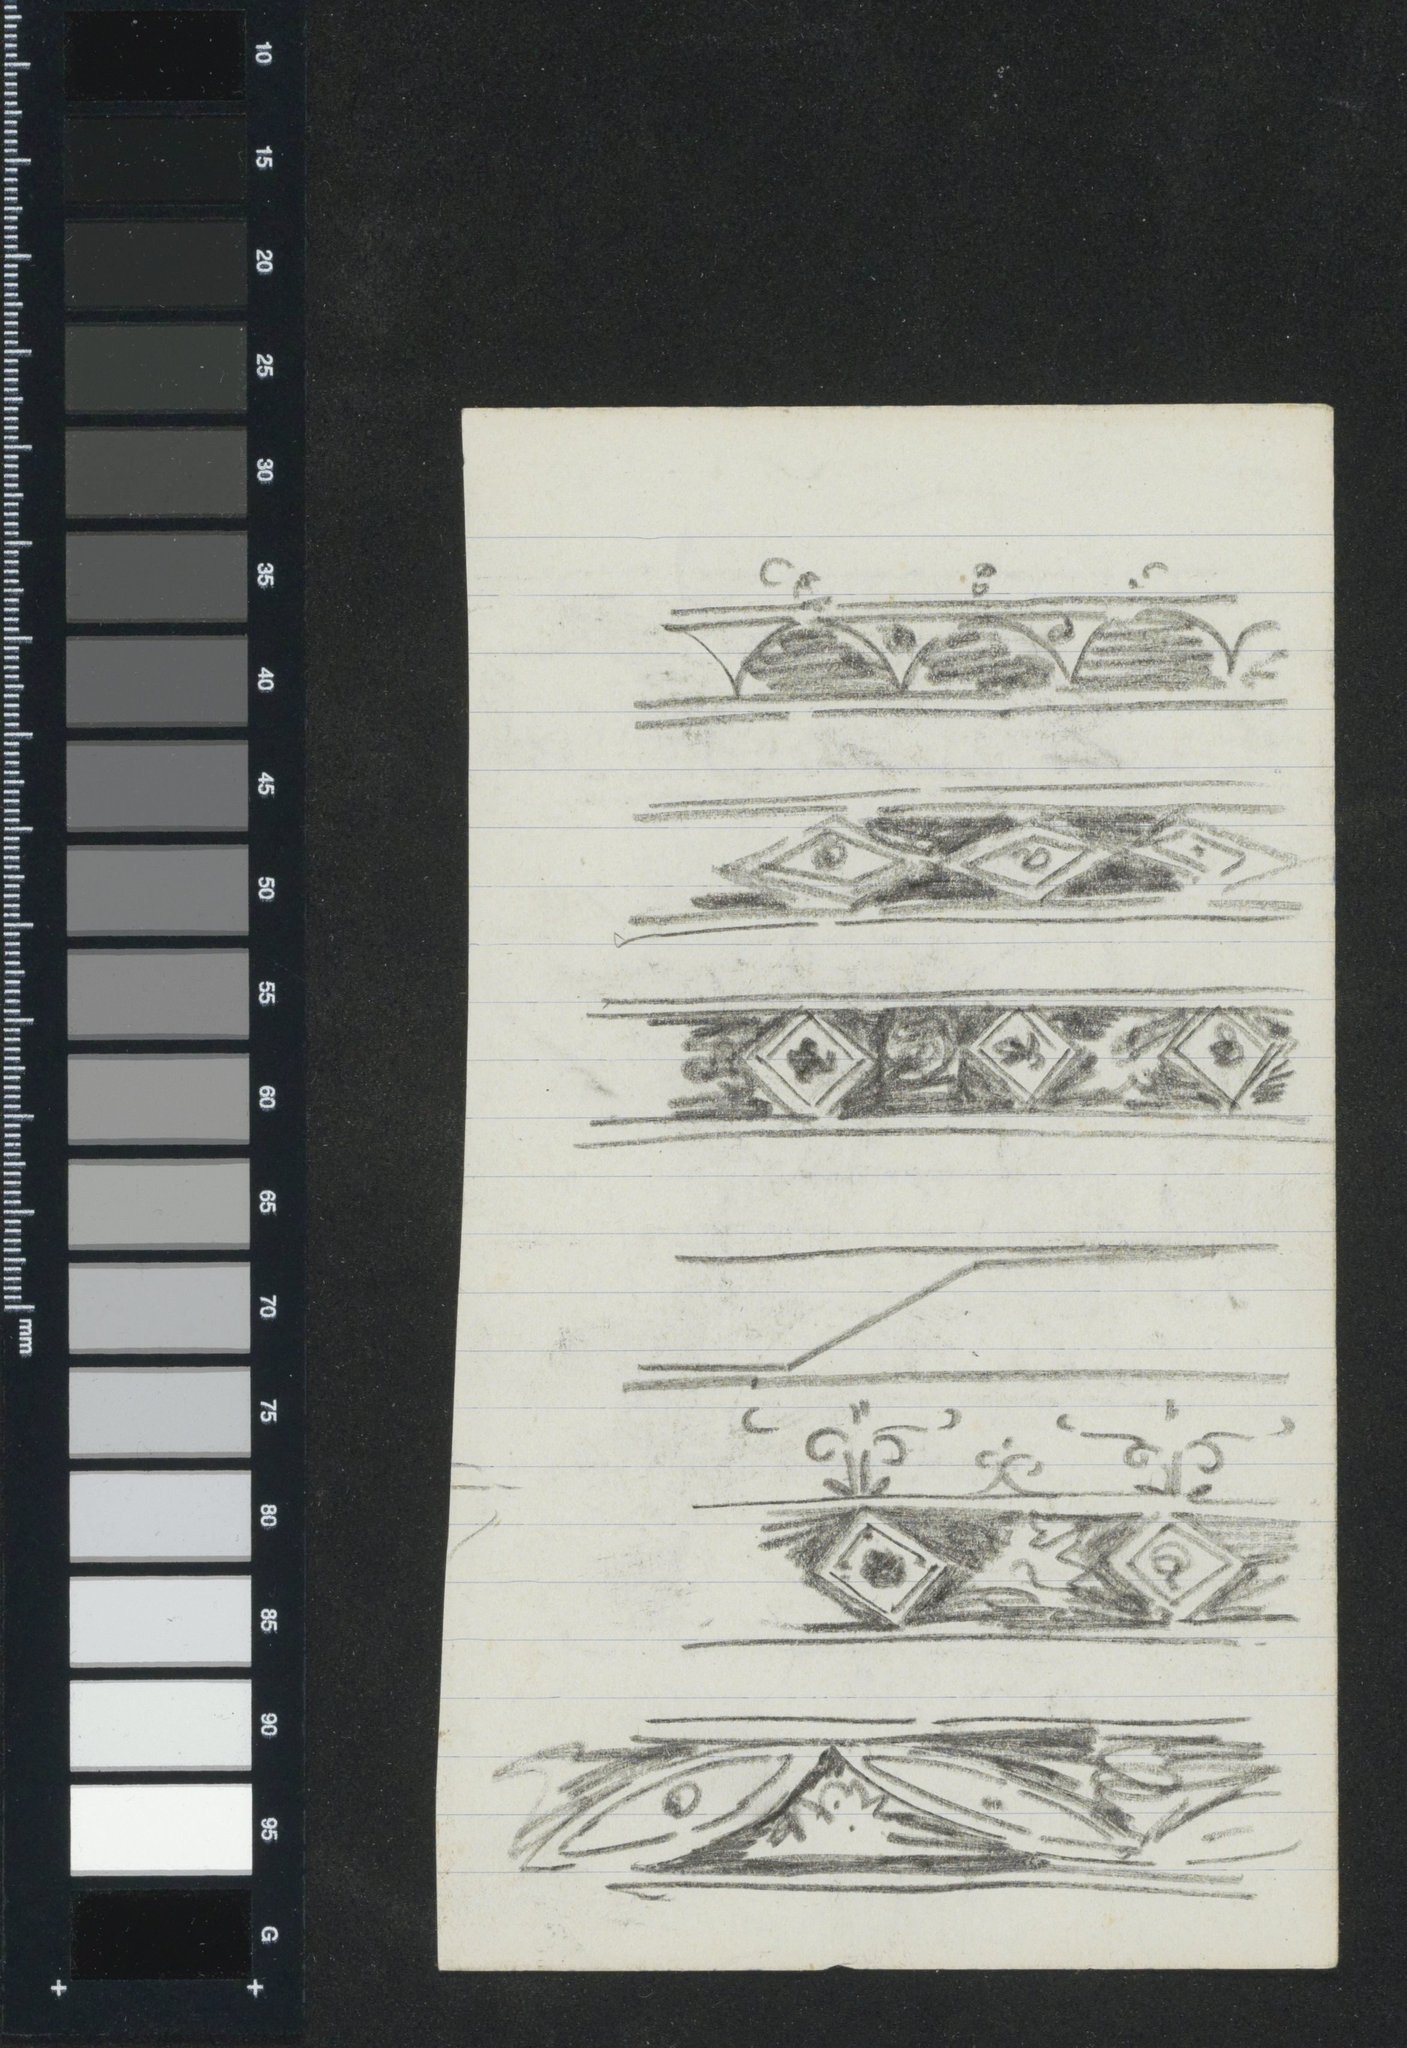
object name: drawing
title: Banden met decoratieve patronen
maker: gerrit willem dijsselhof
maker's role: designer, draughtsman, print maker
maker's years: 1866-1924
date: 1876-1924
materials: chalk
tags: ornaments ~ art